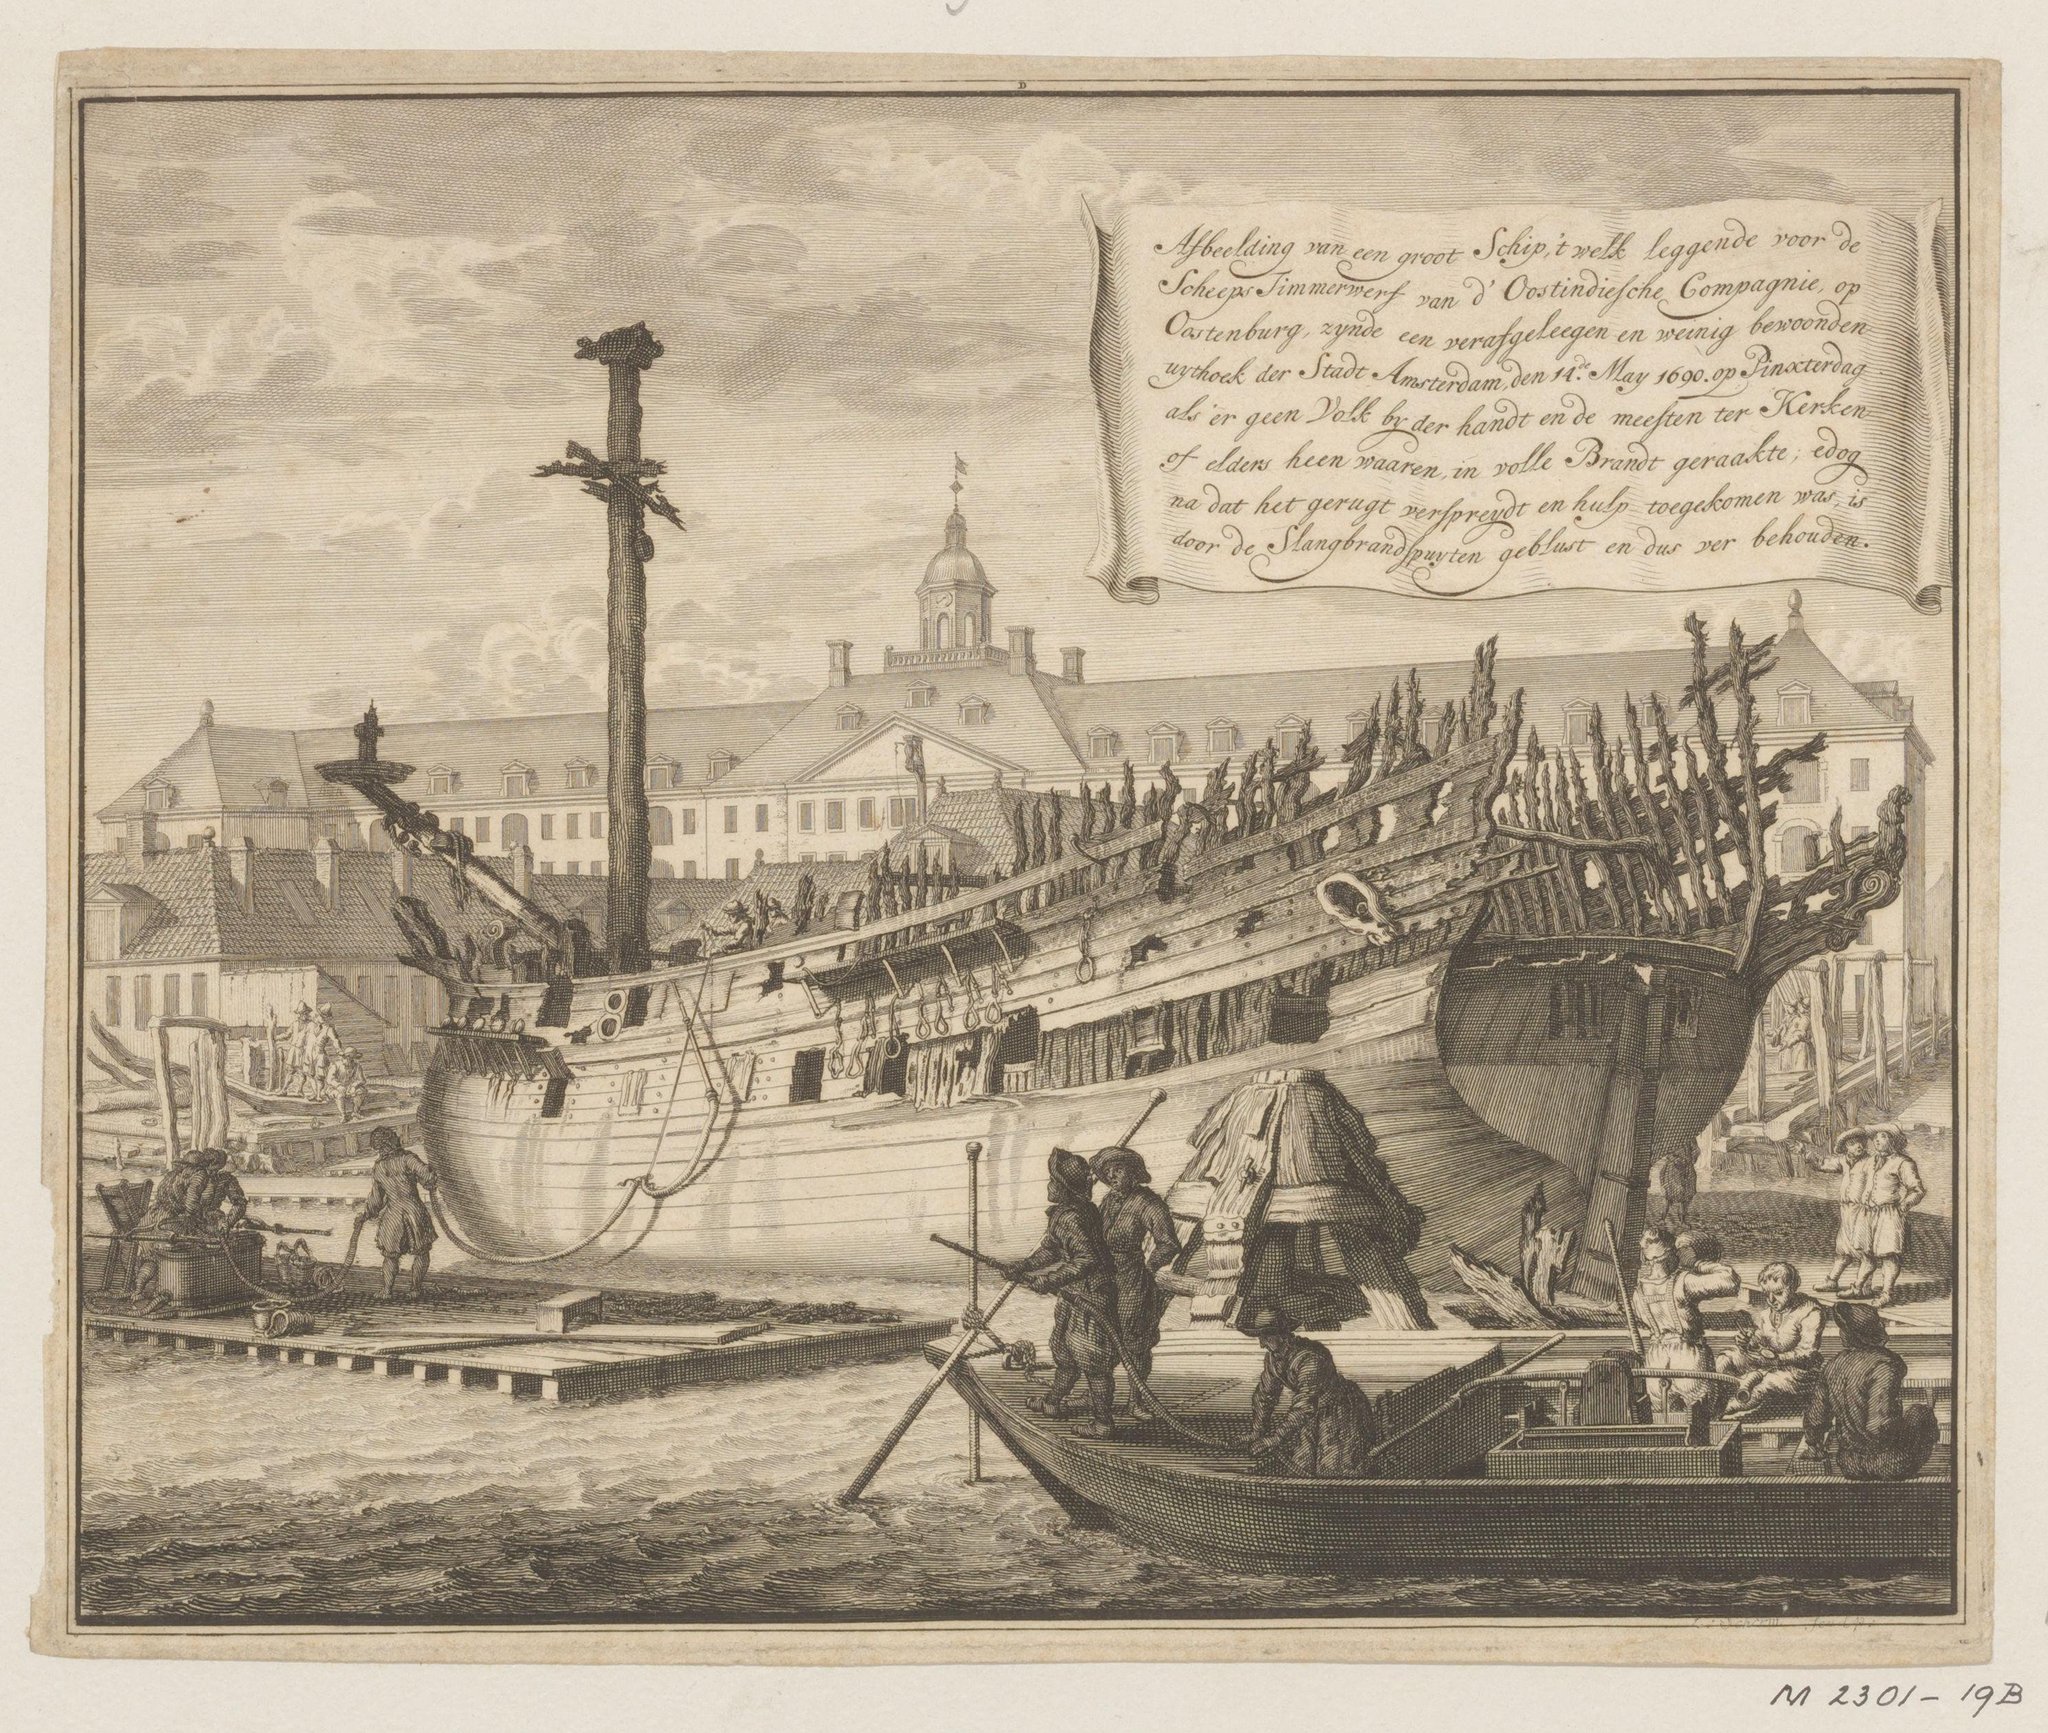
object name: book illustration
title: Afbeelding van een groot schip, 't welk leggende voor de Scheeps Timmerwerf van d' Oostindiesche Compagnie, op Oostenburg (...)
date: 1735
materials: paper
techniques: engraving, etching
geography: amsterdam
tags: print maker, draughtsman, jan van der heyden, building a ship, ship under construction, pump (fire-extinguishing equipment), fire-hose, shipyard, shipdock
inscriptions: collector's mark: Lugt 1641b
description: Schip in aanbouw op de VOC-scheepswerf op Oostenburg dat in brand raakte, maar door het blussen met de slangbrandspuit gered kon worden, 14 mei 1690. Rechtsboven een banderol met opschrift. Plaat in (sommige exemplaren van) de herdruk van het Brandspuitenboek van Jan van der Heyden uit 1735. Onderwerpsrubriek binnen de Atlas Amsterdam: Gemeentewerken: B. Branden in particuliere gebouwen.